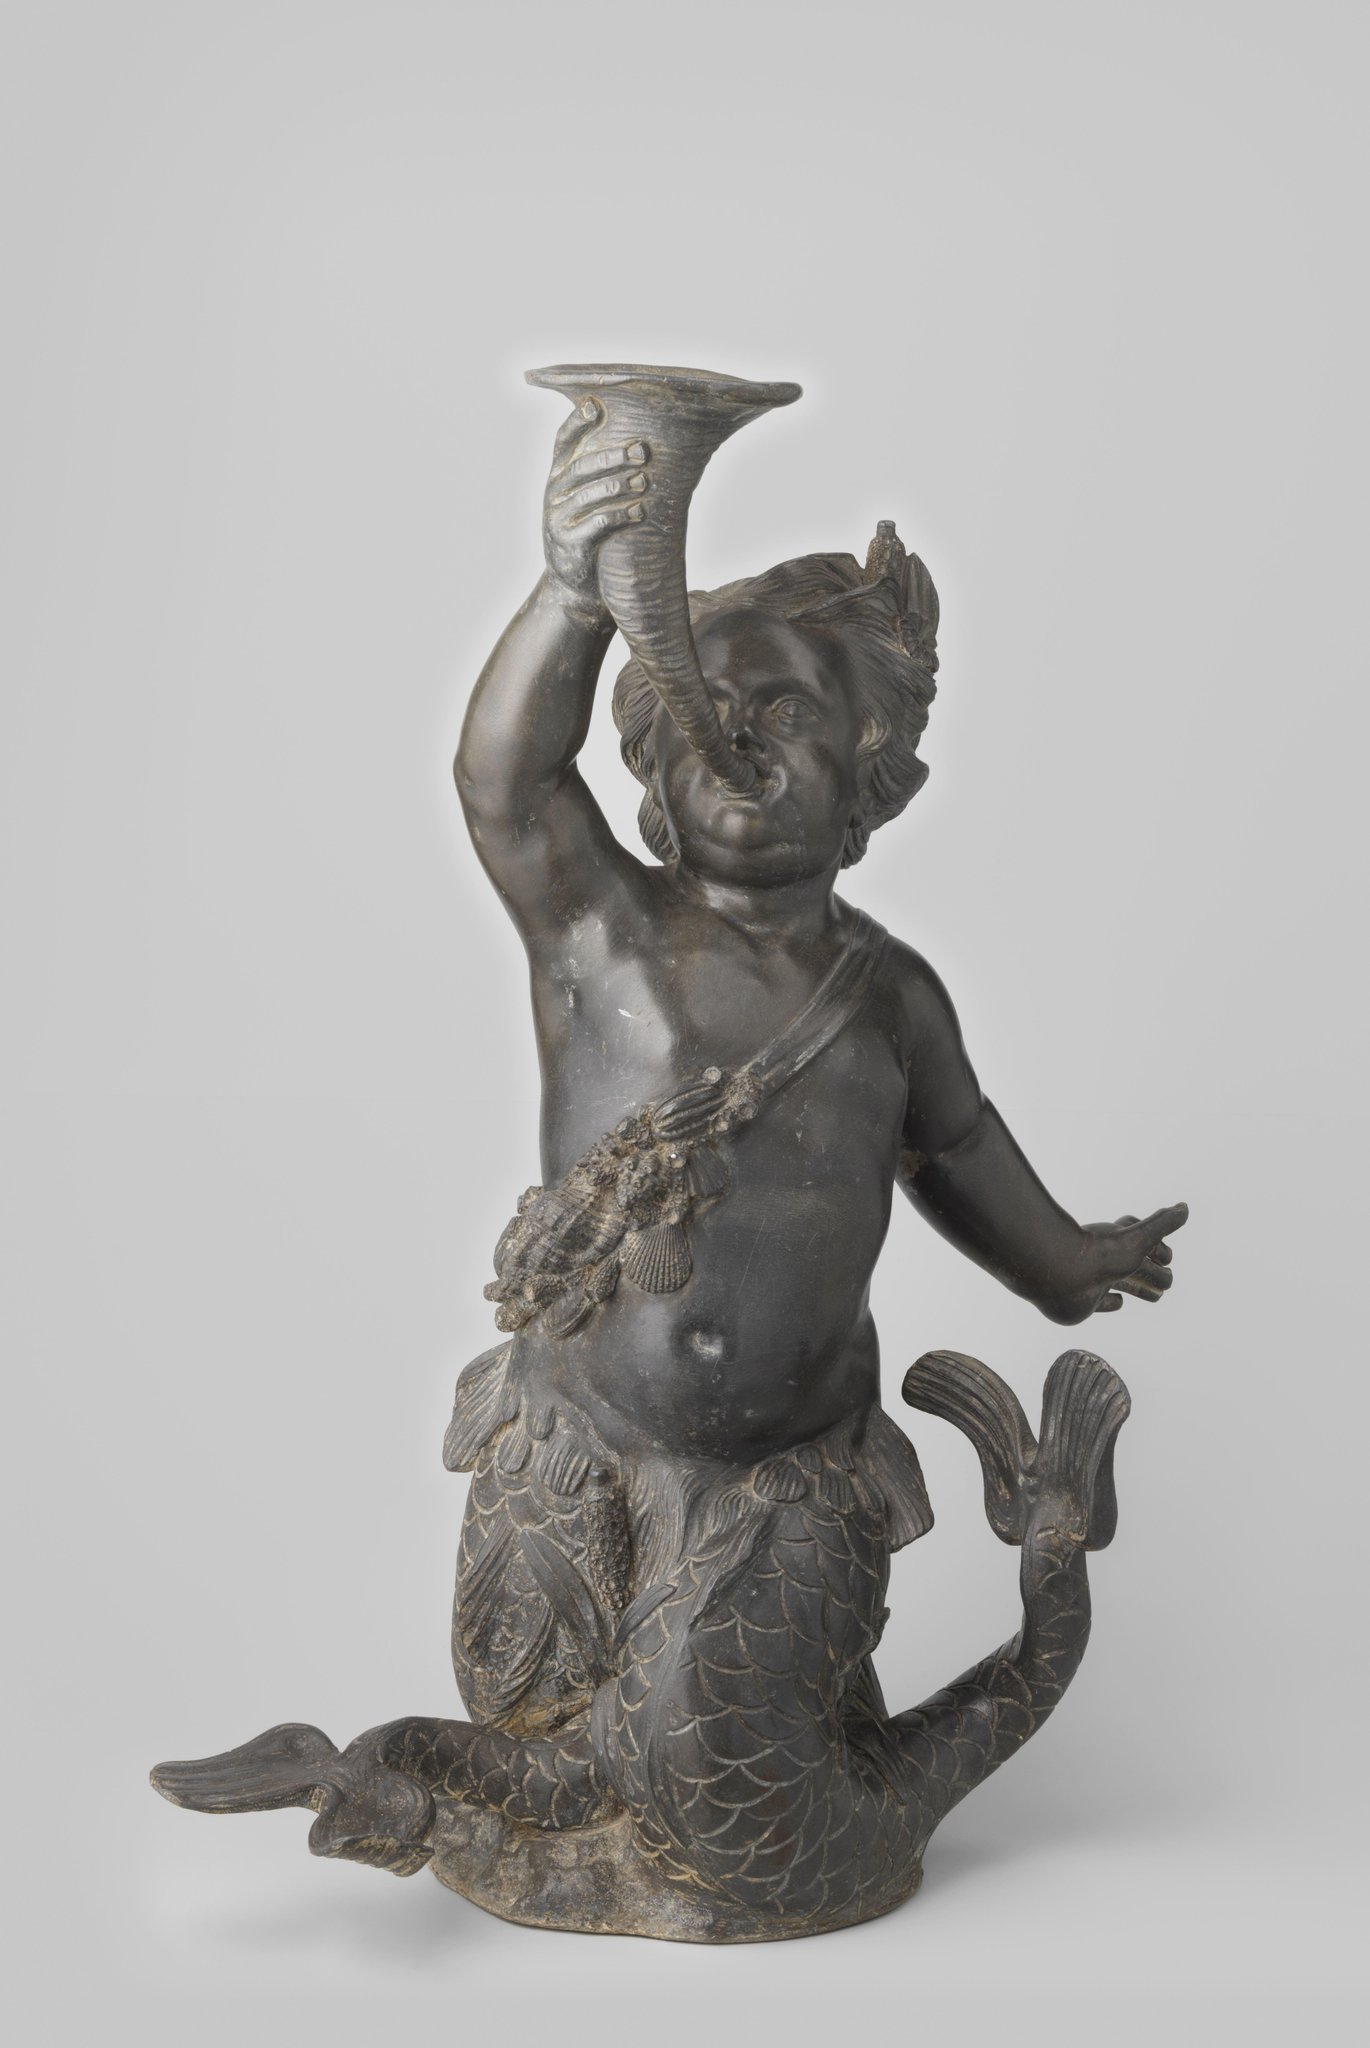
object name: sculpture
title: Jonge zeemeermin, fonteinfiguur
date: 1700-1725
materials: lead